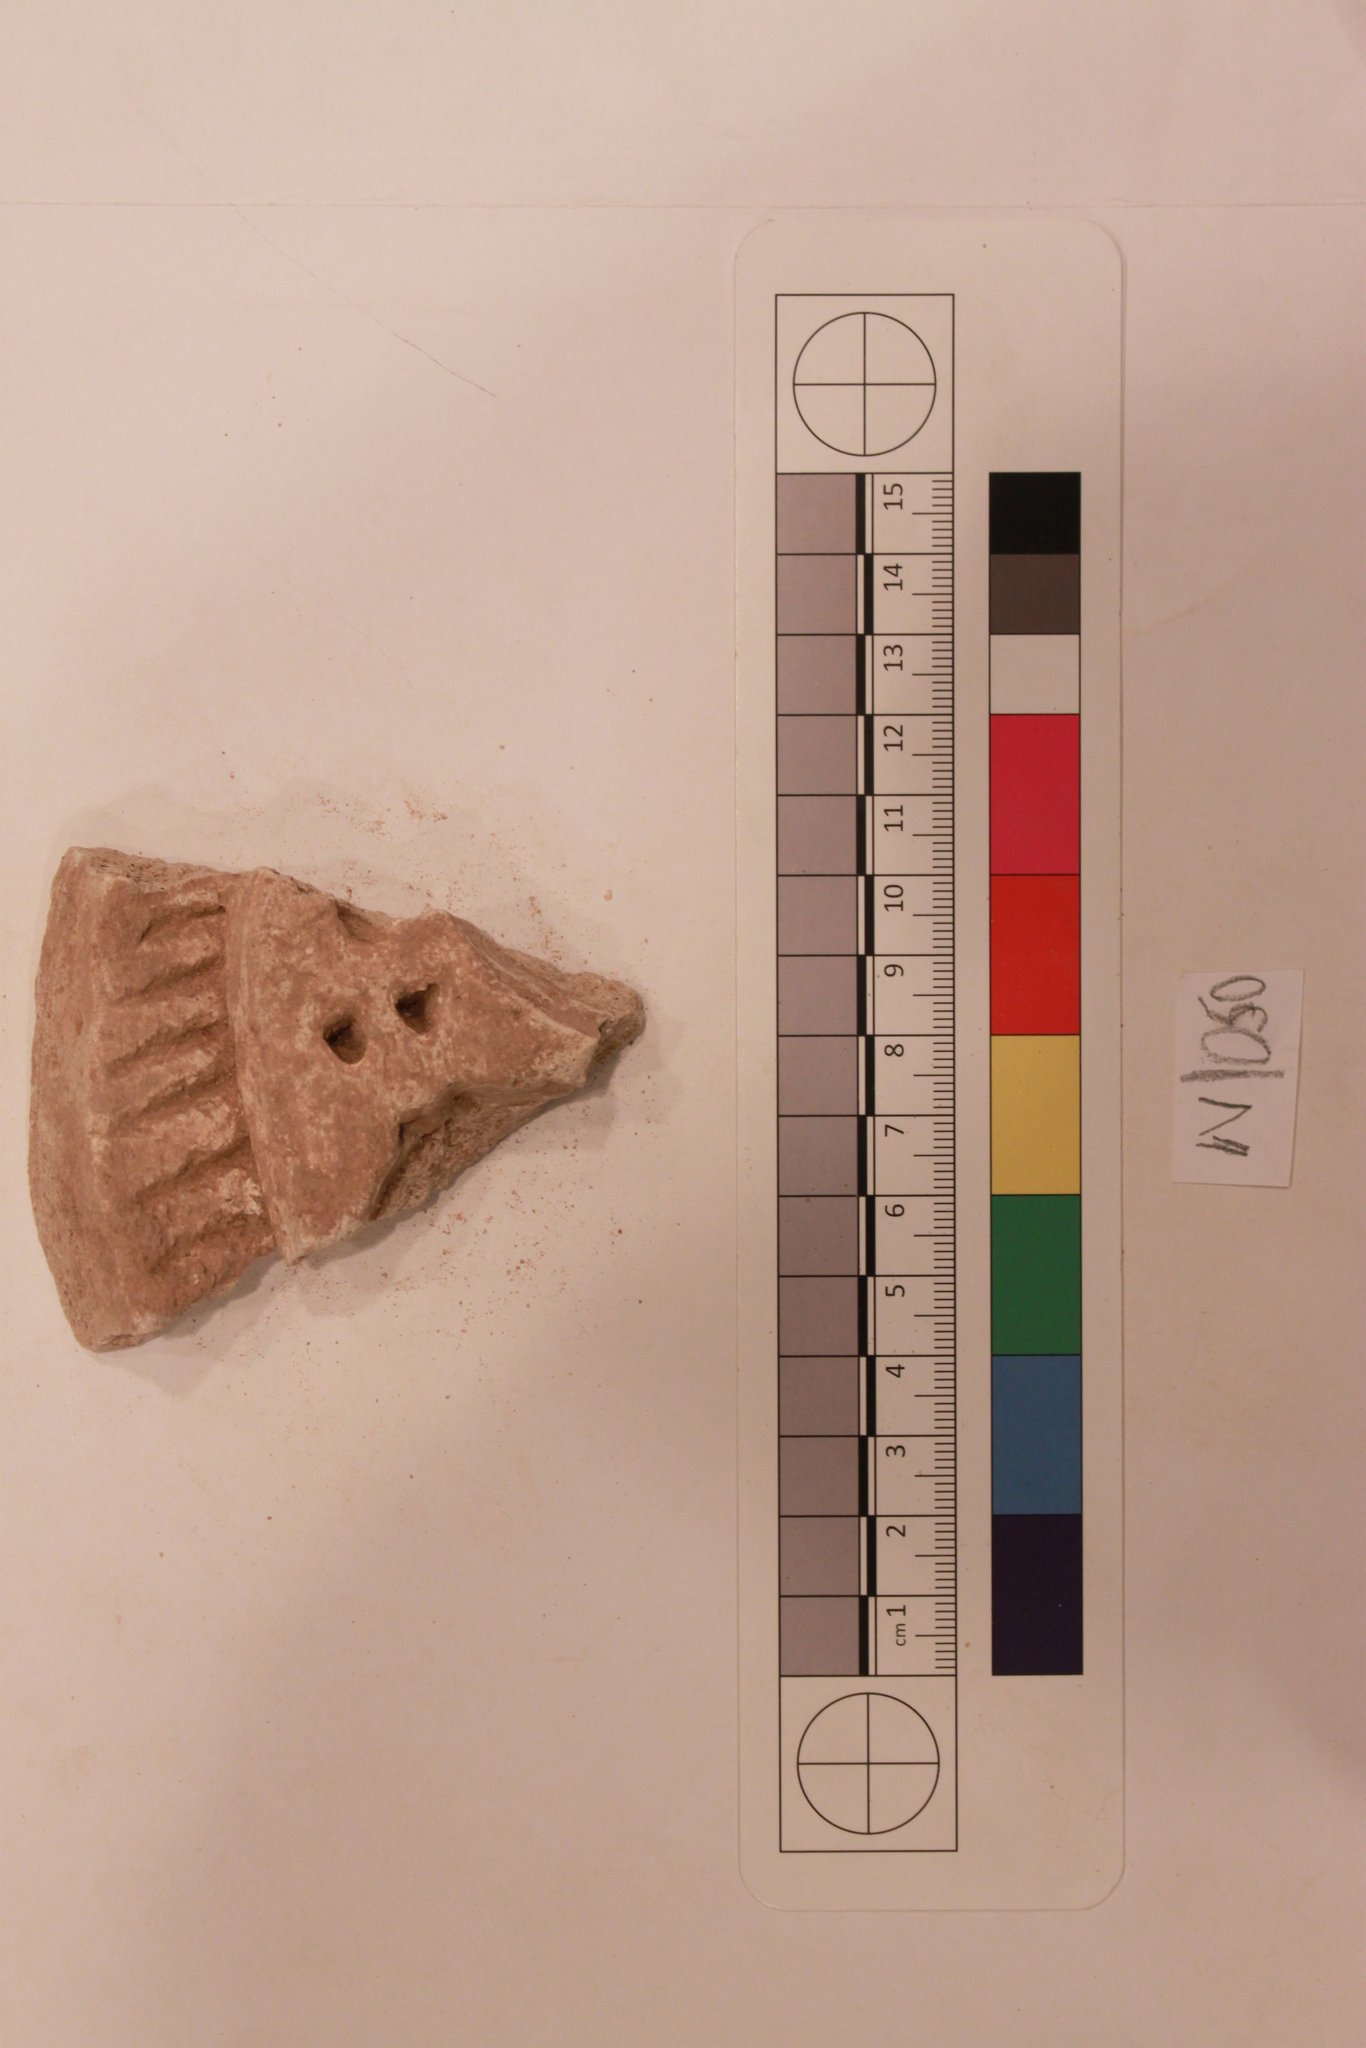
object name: fragment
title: Stucco Fragment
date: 701-1200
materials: plaster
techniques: carving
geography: iran